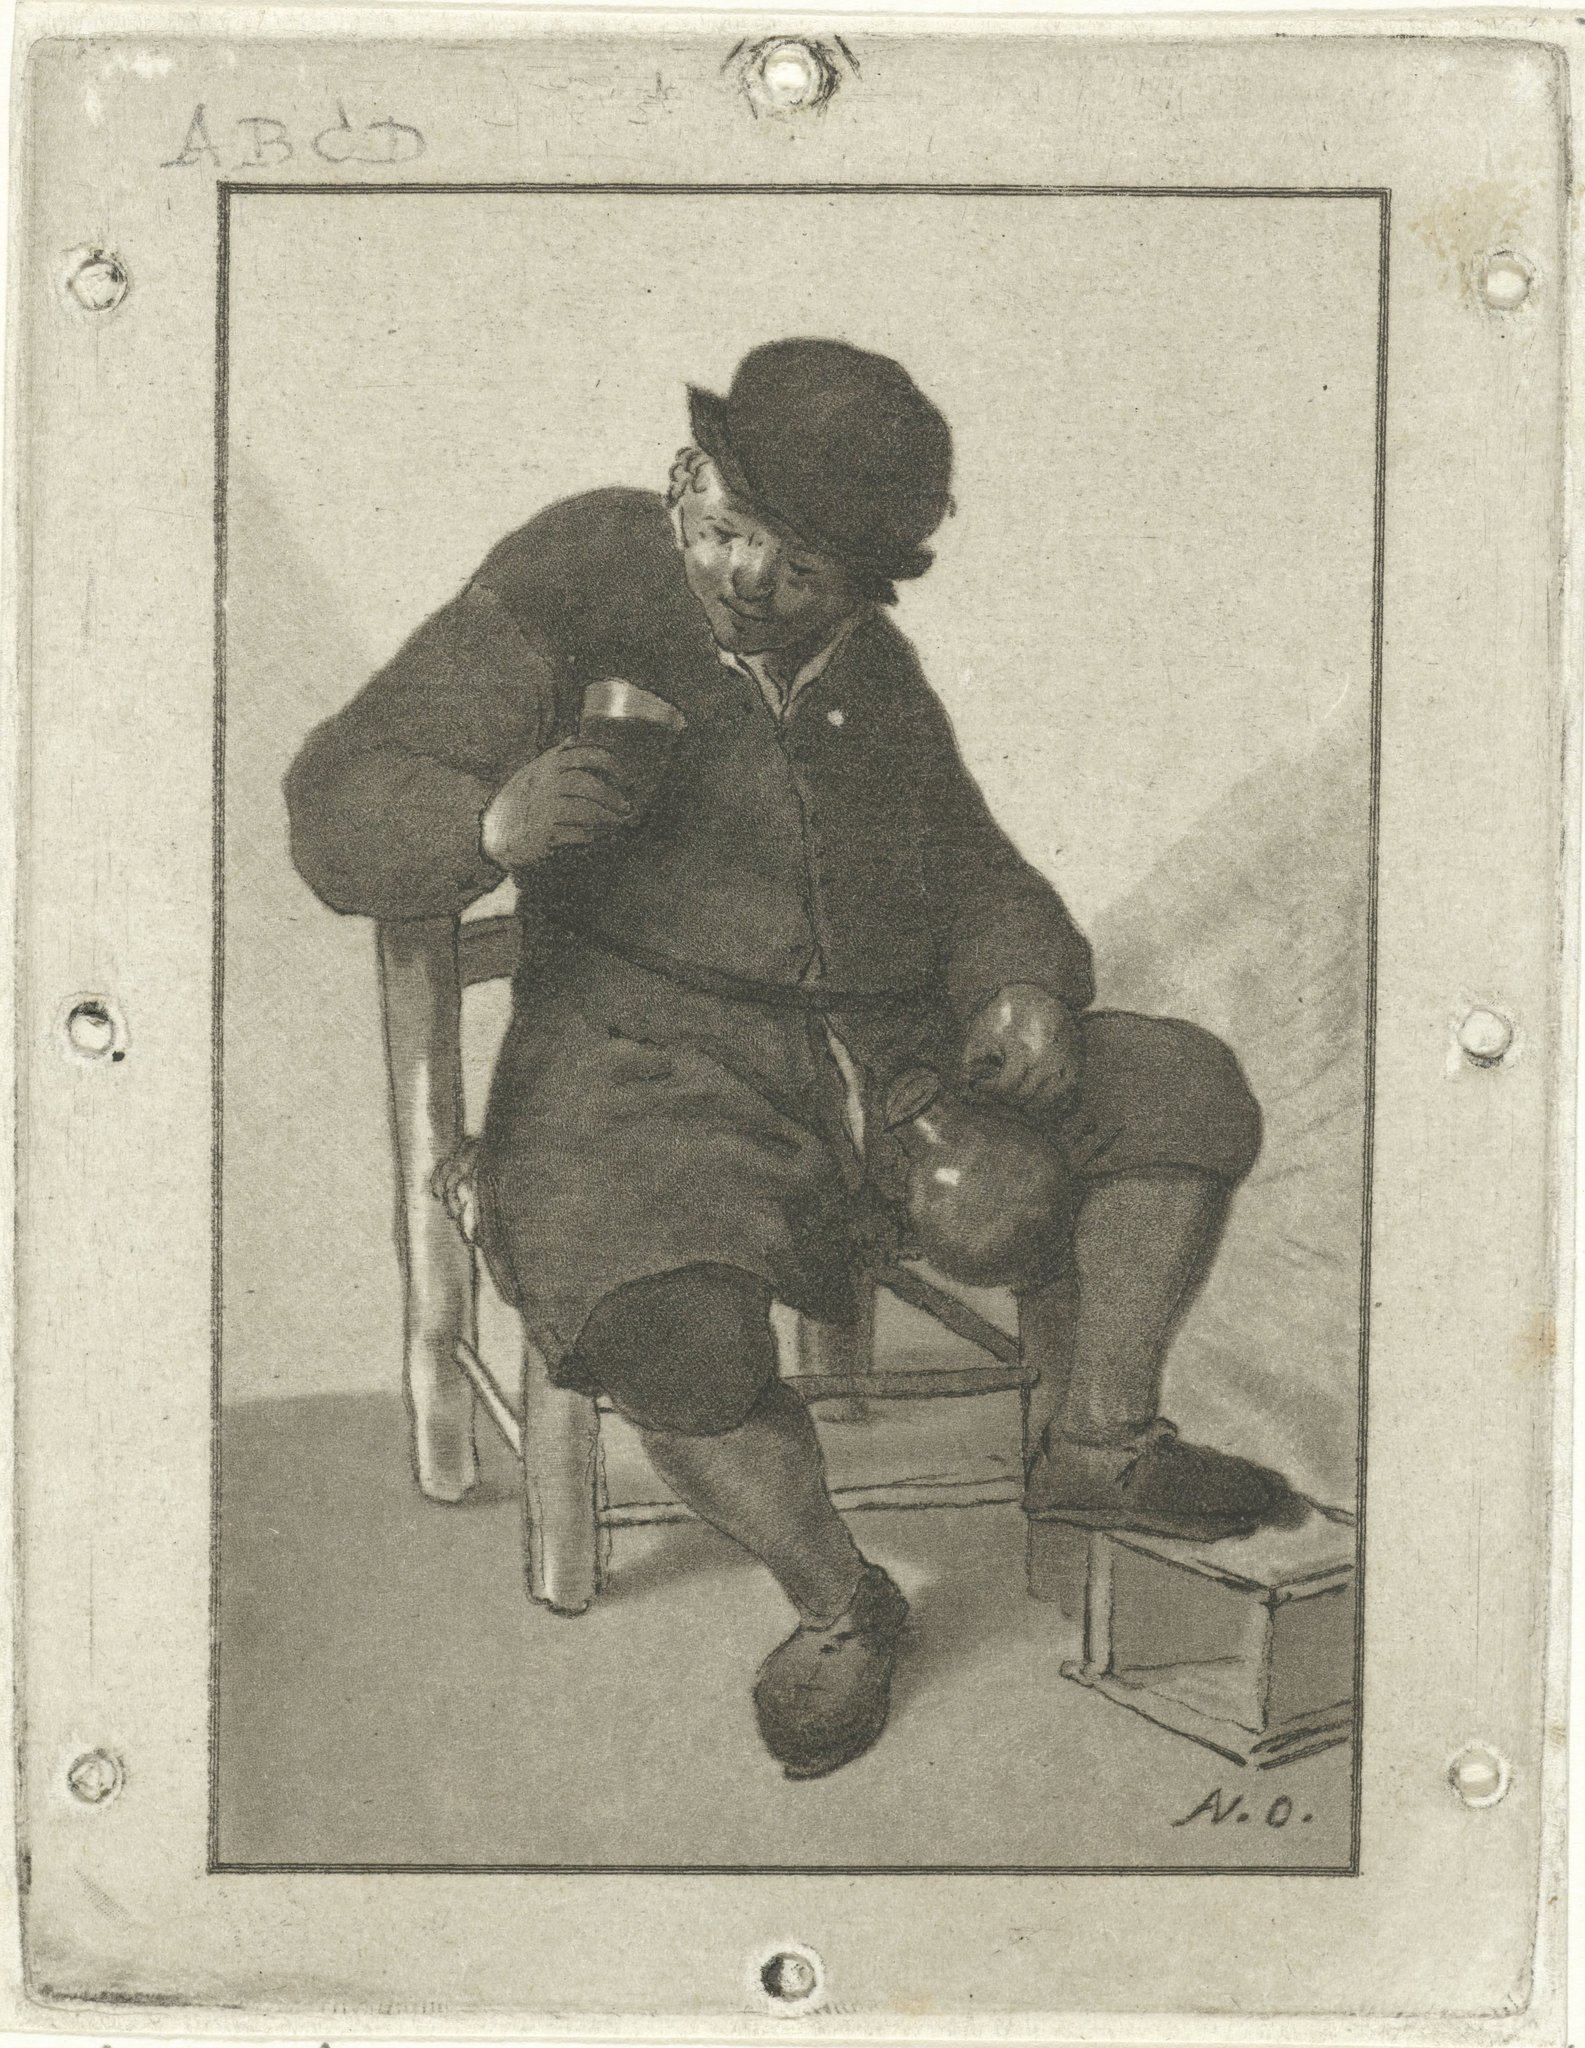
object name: print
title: Zittende boer met kruik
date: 1763-1768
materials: paper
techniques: etching, roulette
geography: amsterdam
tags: sitting figure, jar, jug (used as drinking-vessel)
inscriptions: collector's mark: Lugt 2228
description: Voor deze prenttekening, 'Zittende boer met kruik', maakte Ploos van Amstel vier verschillende platen (A, B, C, en D). Er bestaan afdrukken van één, twee, drie of alle vier de platen in alle mogelijke combinaties. Zie gerelateerde objecten voor de hier gebruikte platen.